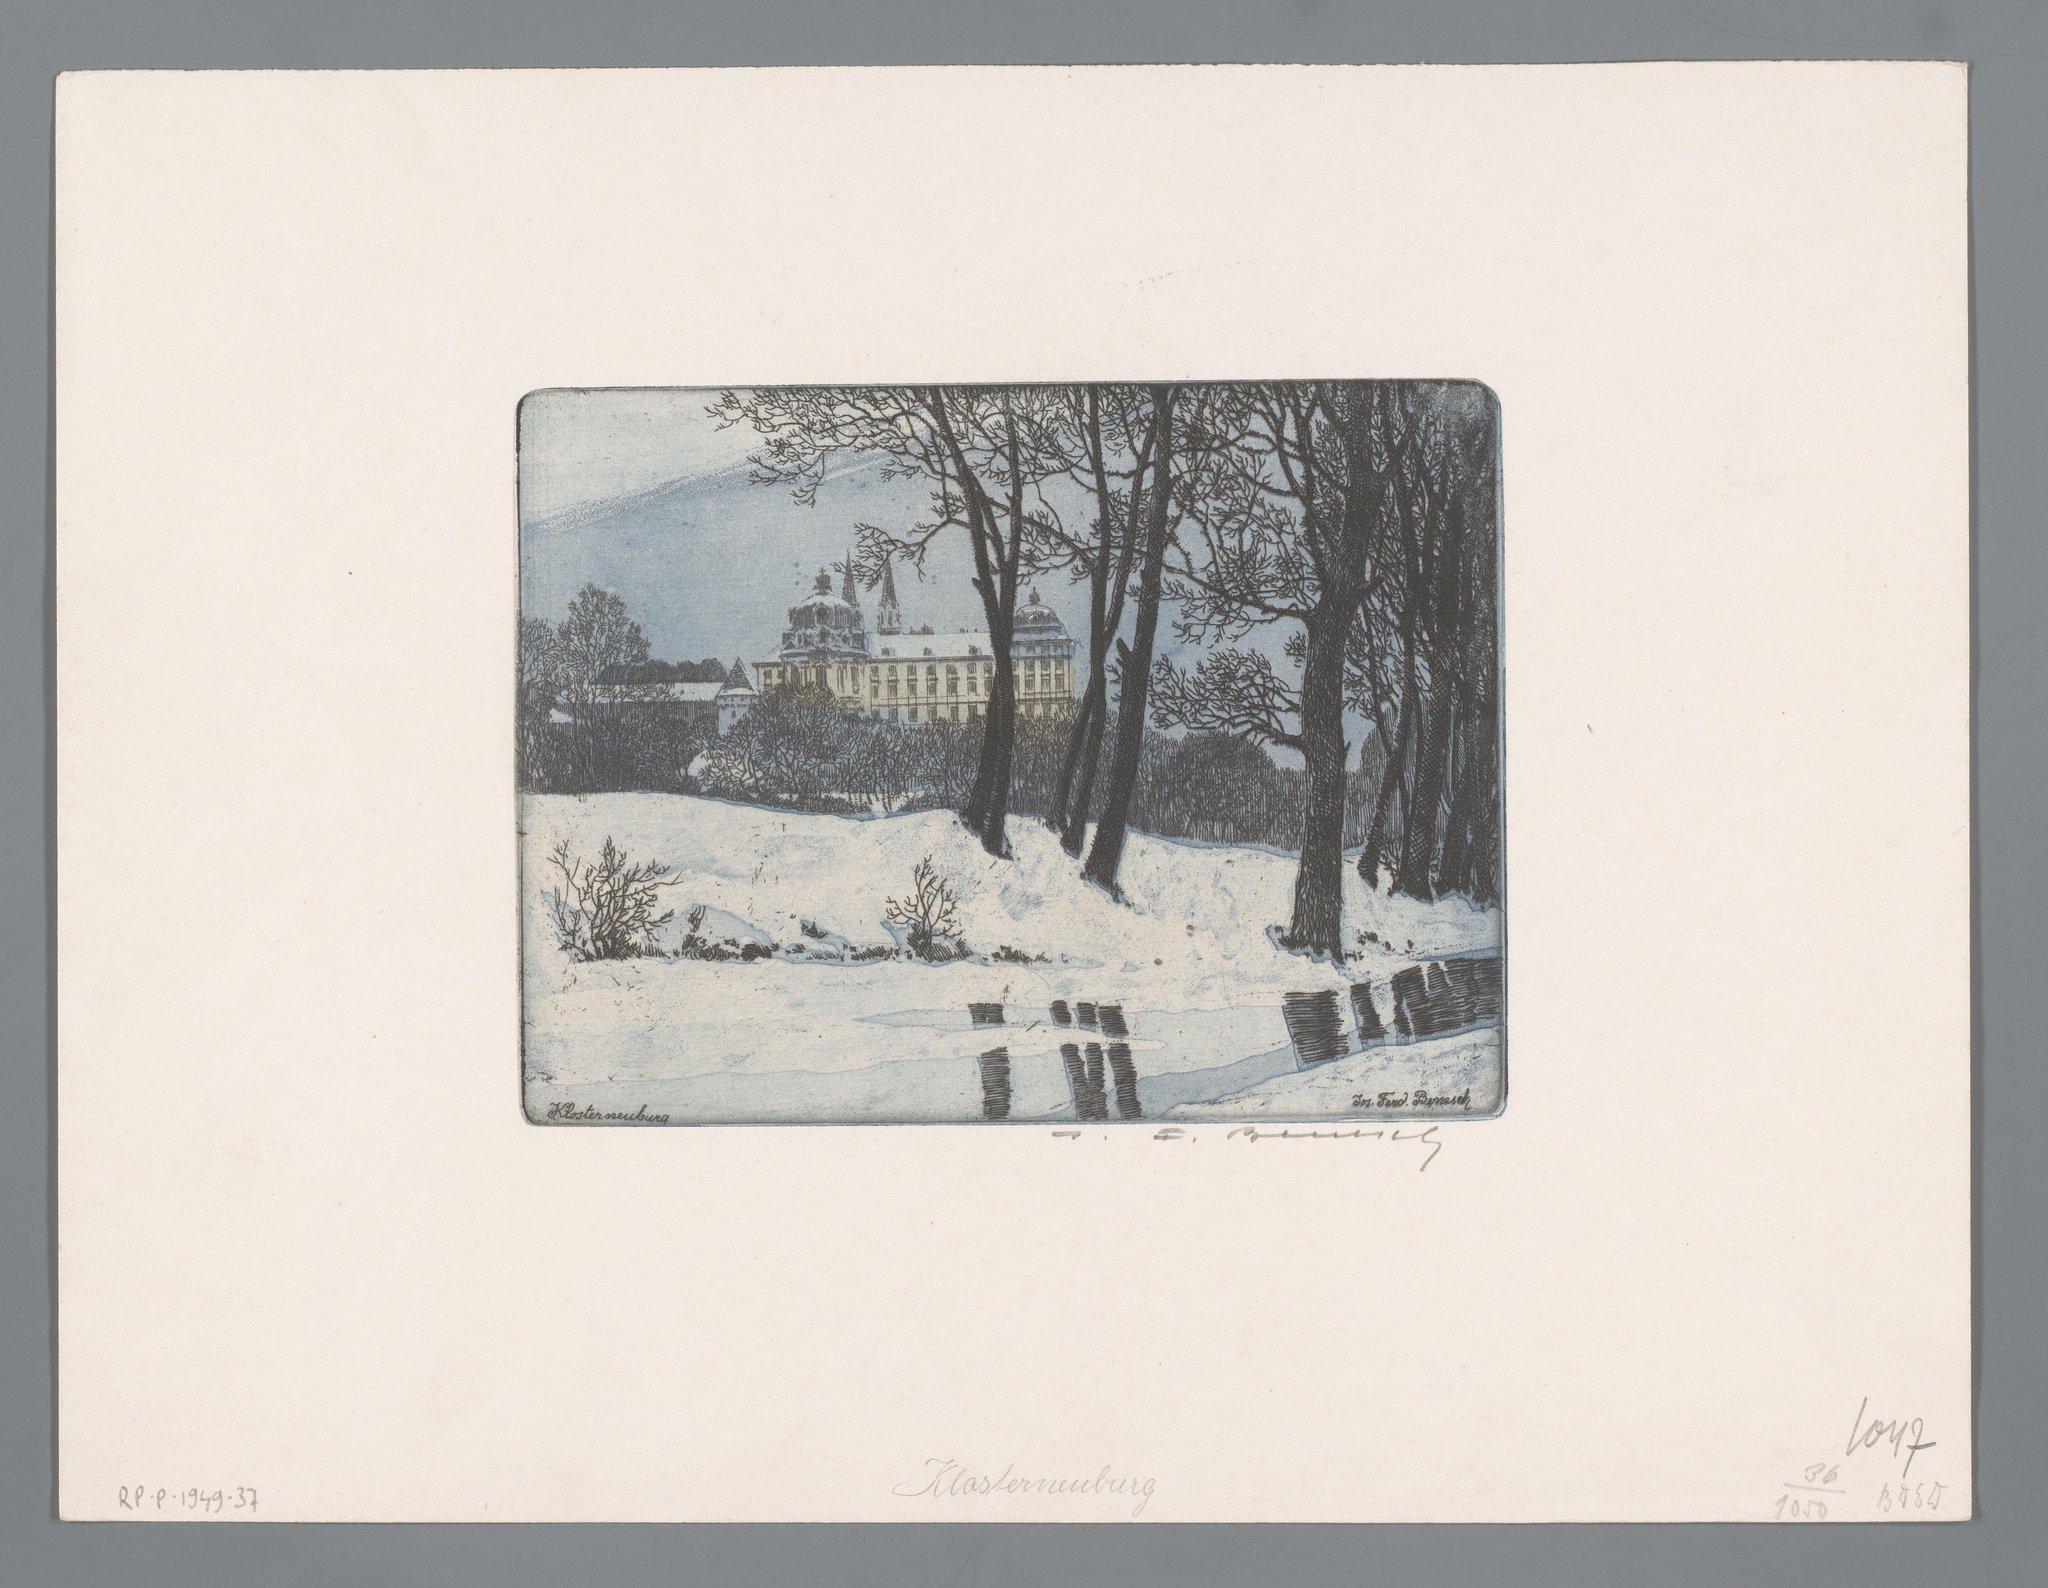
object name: print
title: Klosterneuburg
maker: josef ferdinand benesch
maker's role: print maker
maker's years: 1875-1954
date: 1885-1949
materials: paper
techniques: aquatint, etching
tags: palace, snow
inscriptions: collector's mark: Lugt 2228